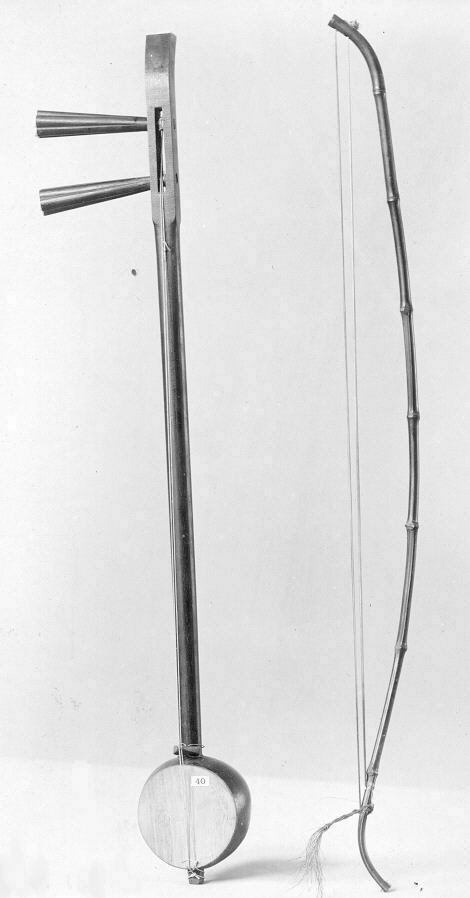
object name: tiqin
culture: chinese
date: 1801-1900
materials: bamboo, hair, silk, wood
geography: china